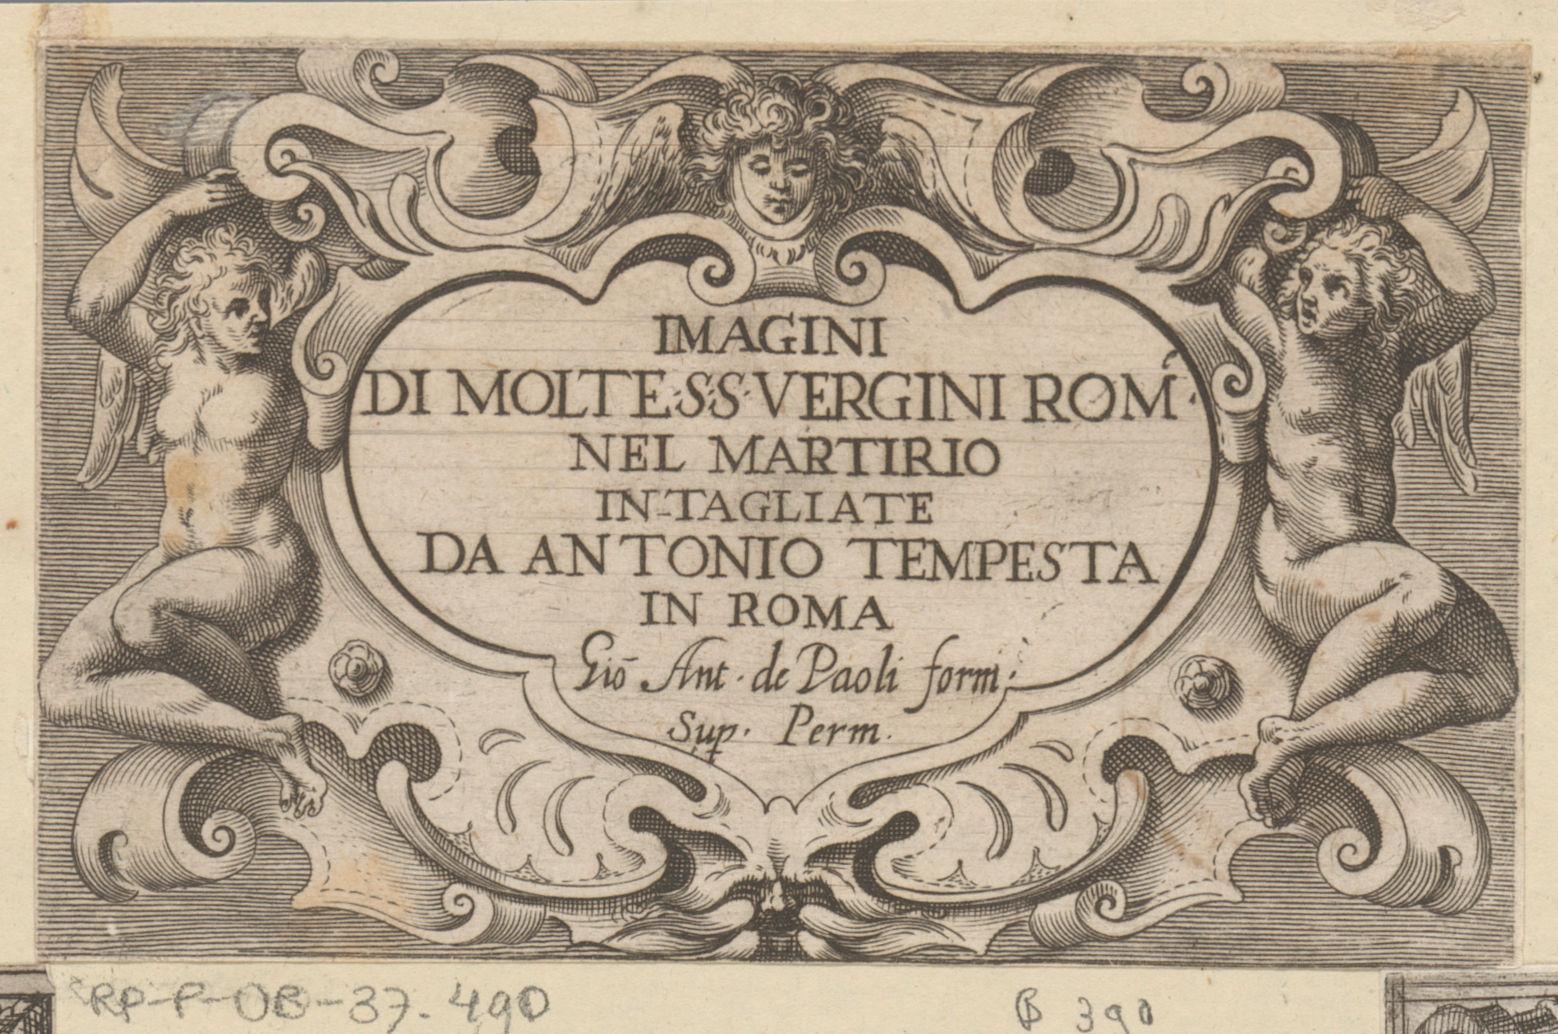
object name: print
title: Romeinse martelaressen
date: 1565-1630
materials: paper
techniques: etching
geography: rome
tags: cherubs, i.e. children's heads with wings, the (nude) human figure; 'corpo humano' (ripa), ornament ~ cartouche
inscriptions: collector's mark: Lugt 240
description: Titelprent bij een reeks van 73 prenten met voorstellingen van Romeinse martelaressen.